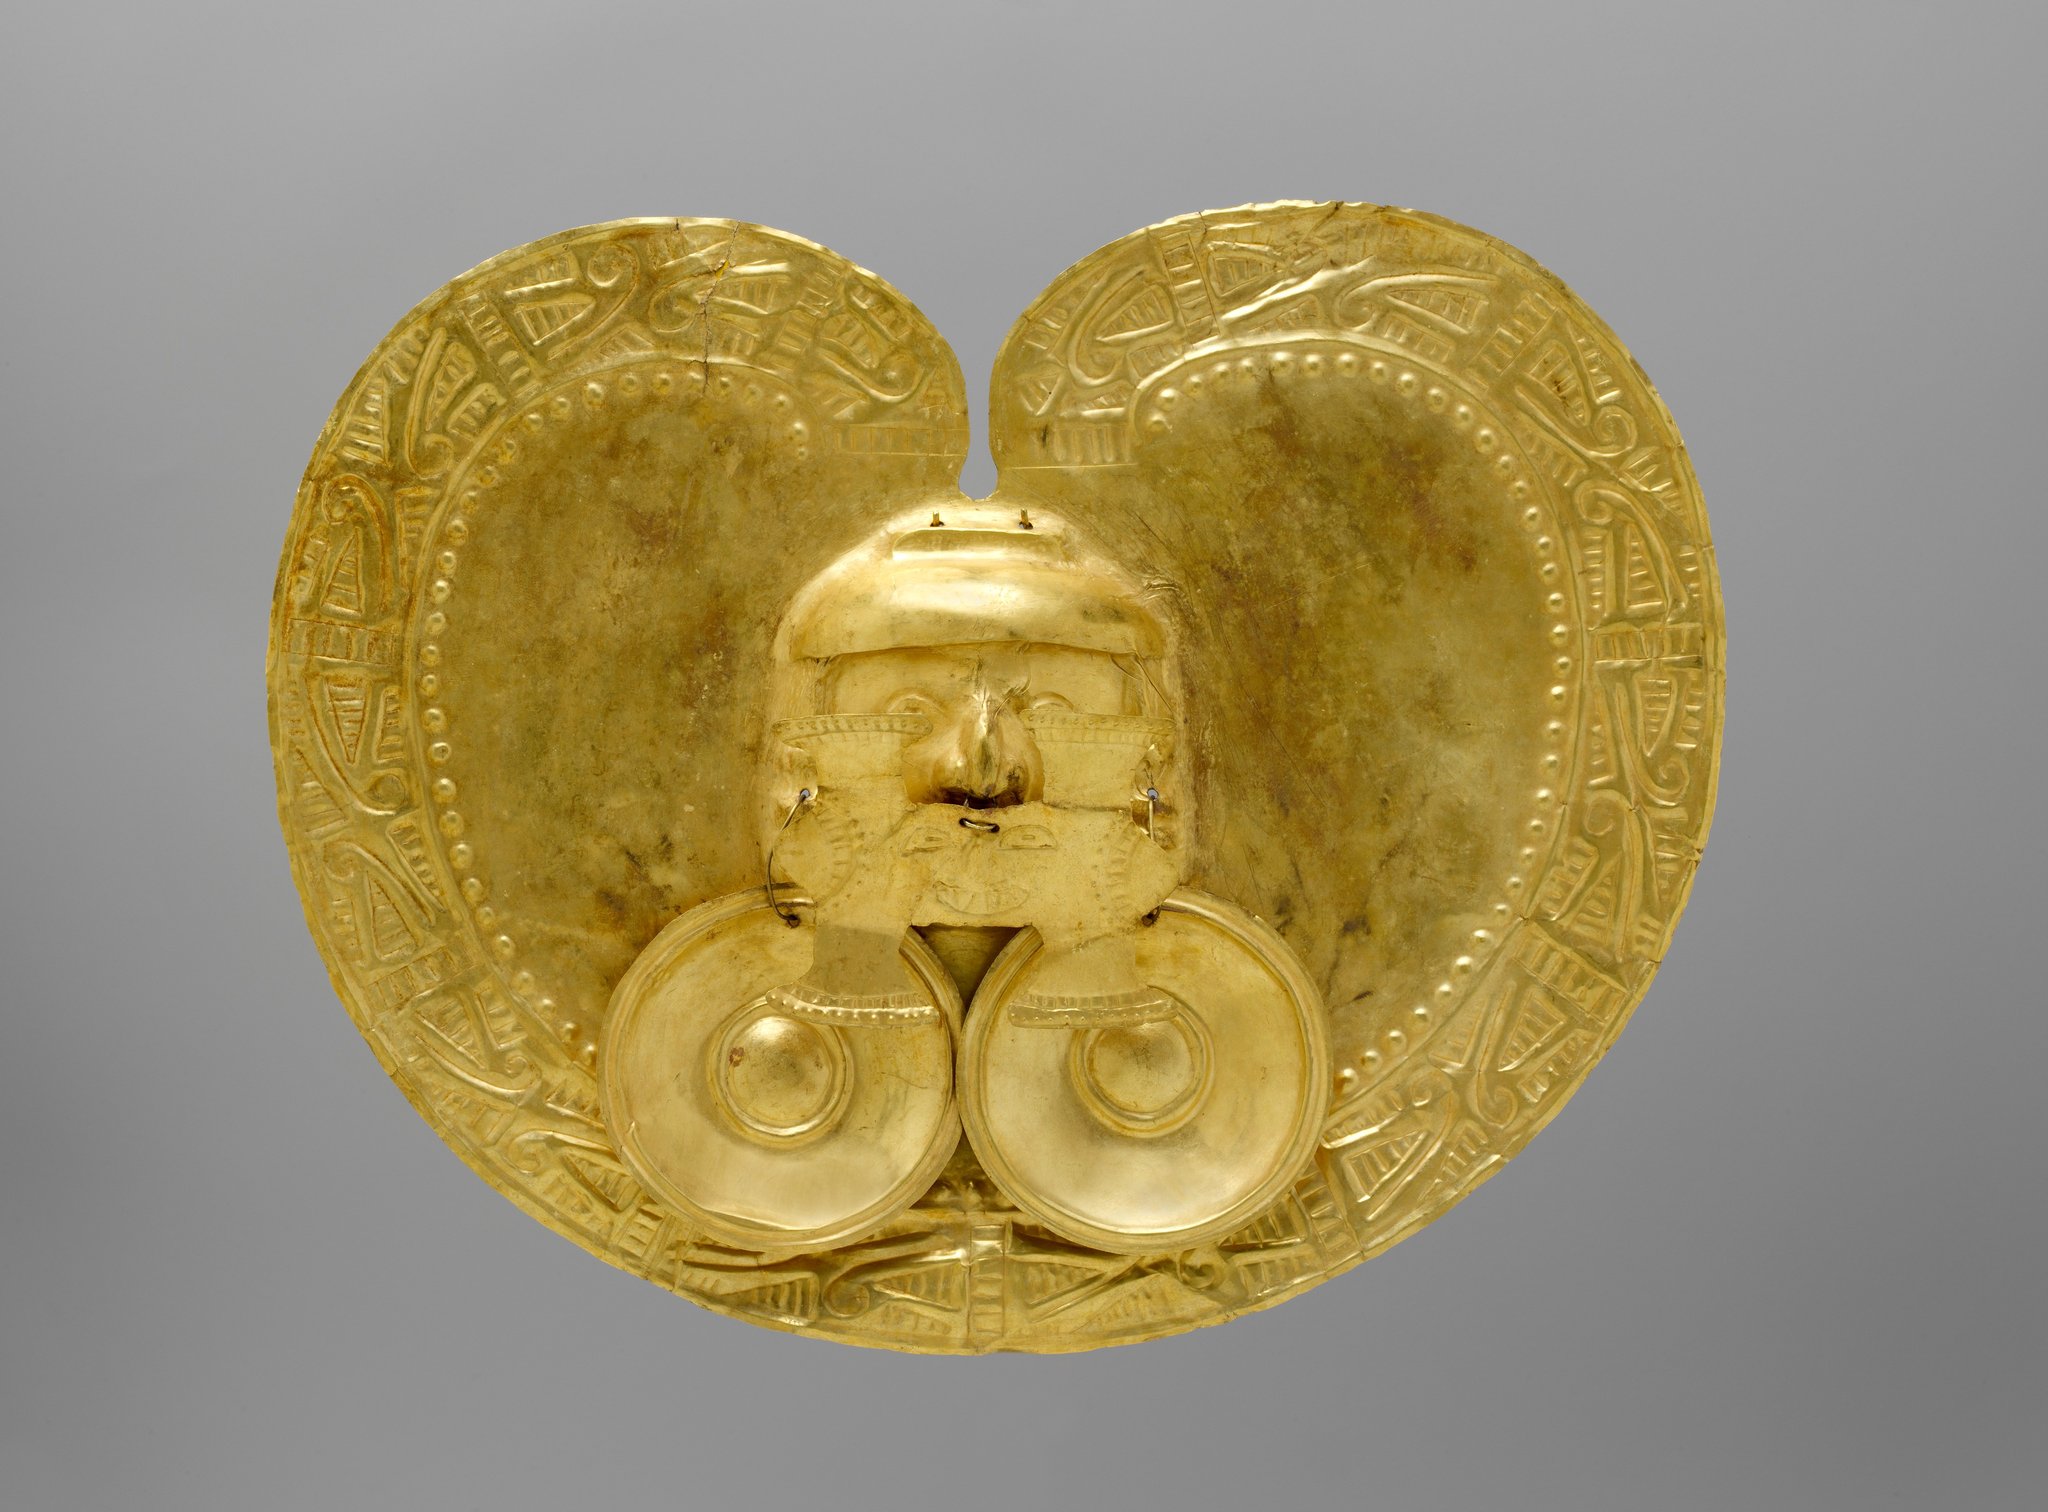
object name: pectoral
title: Pectoral with Face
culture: calima or yotoco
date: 1-700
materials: gold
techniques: hammering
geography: colombia